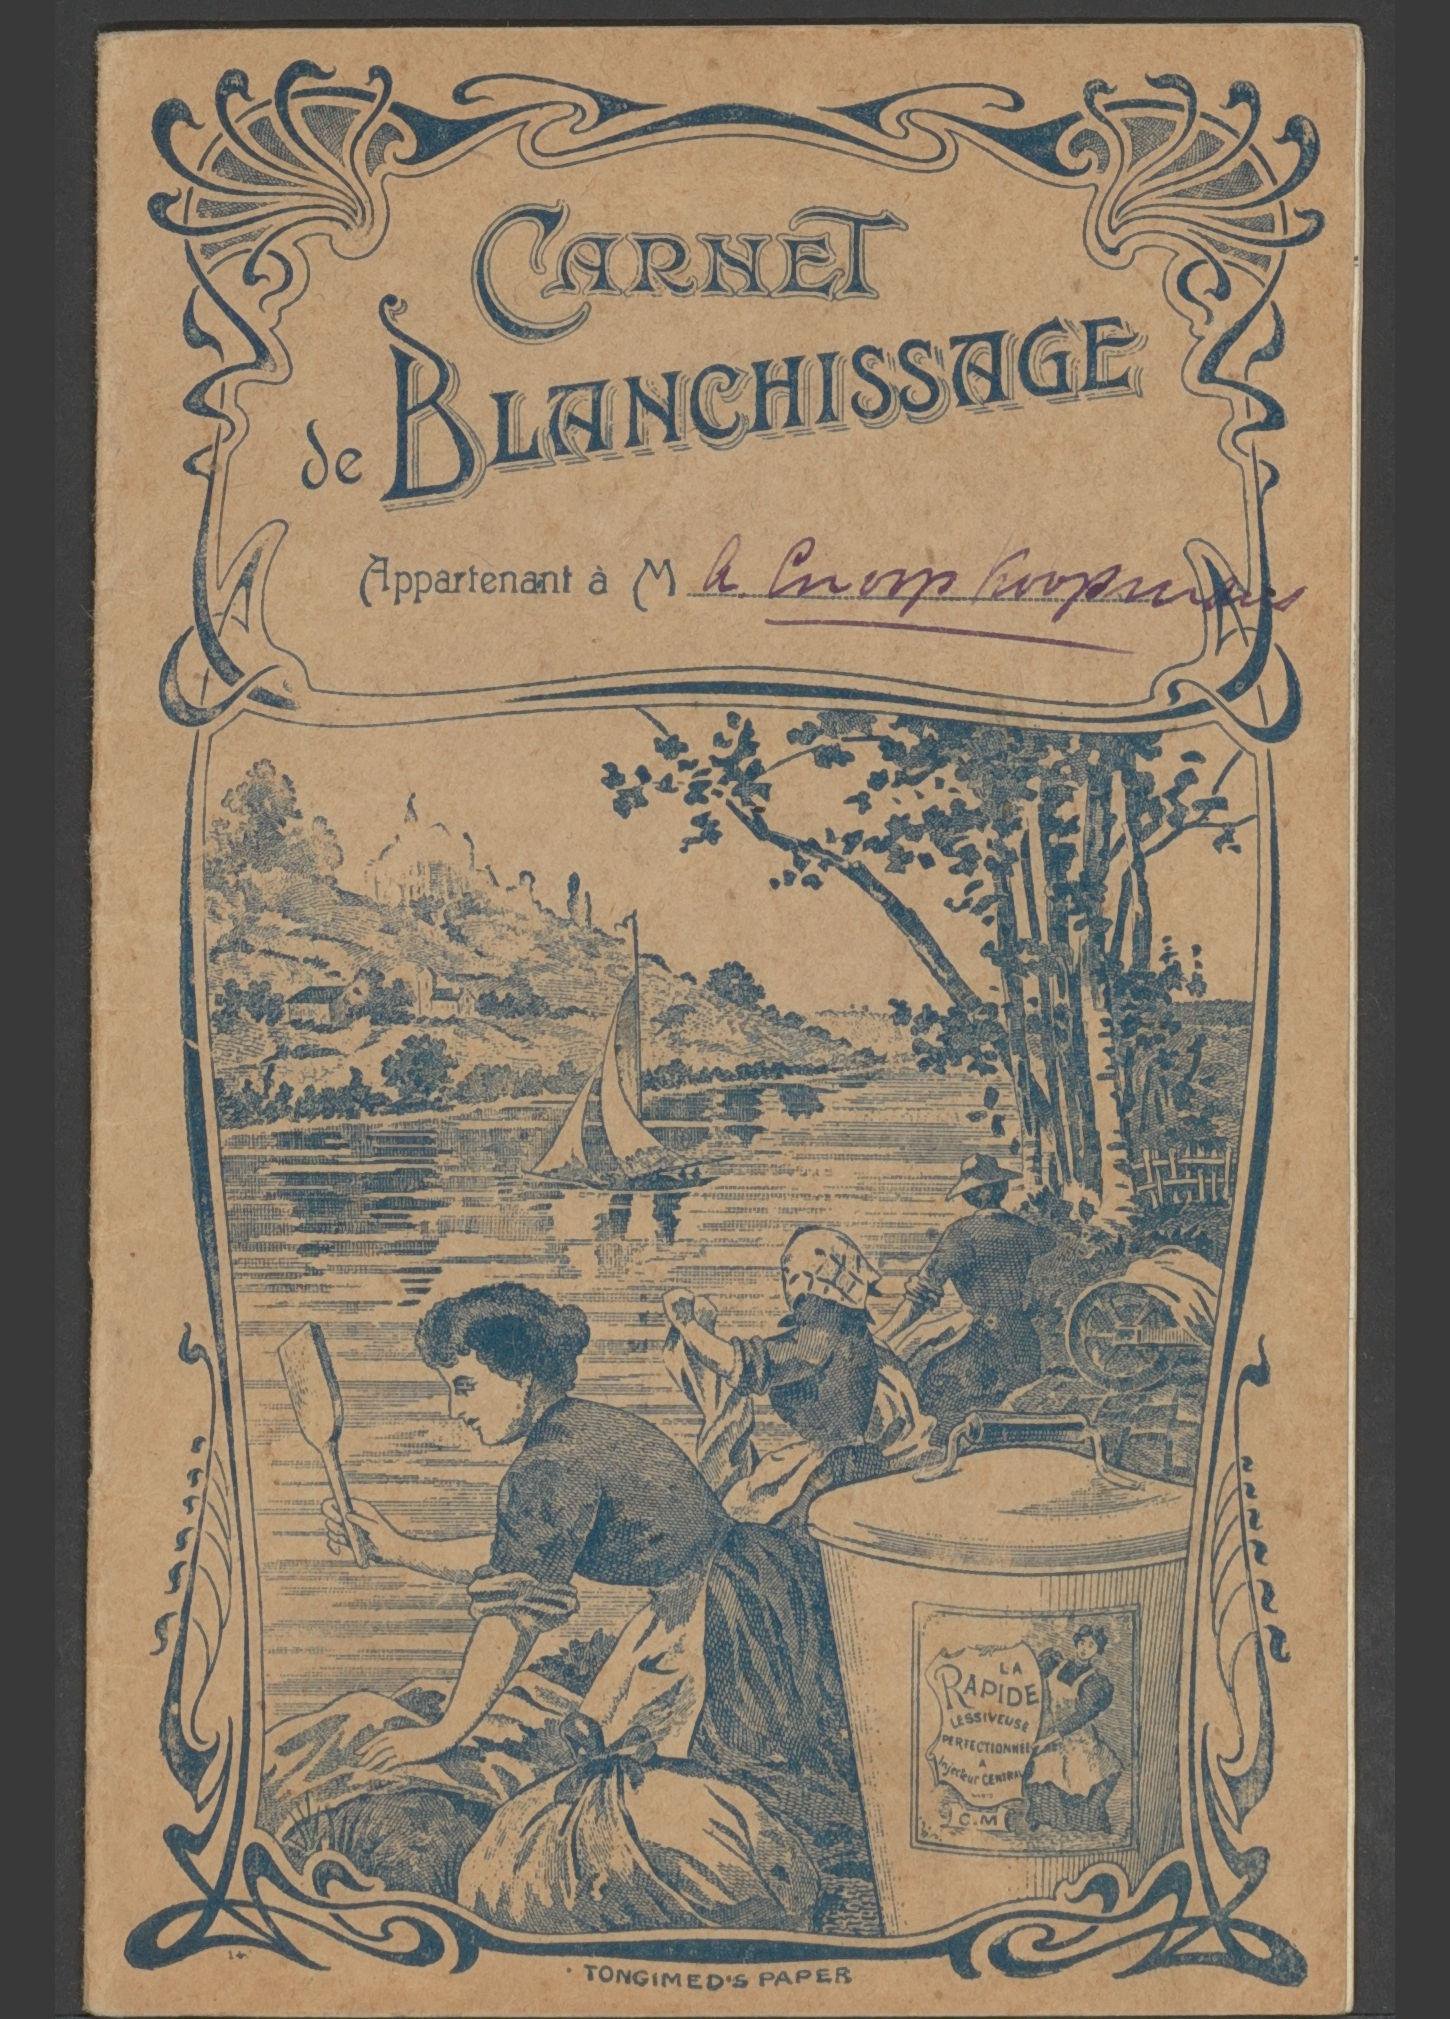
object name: notebook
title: Wasboekje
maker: Anonymous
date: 1910-1919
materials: paper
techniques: lithograph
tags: laundering